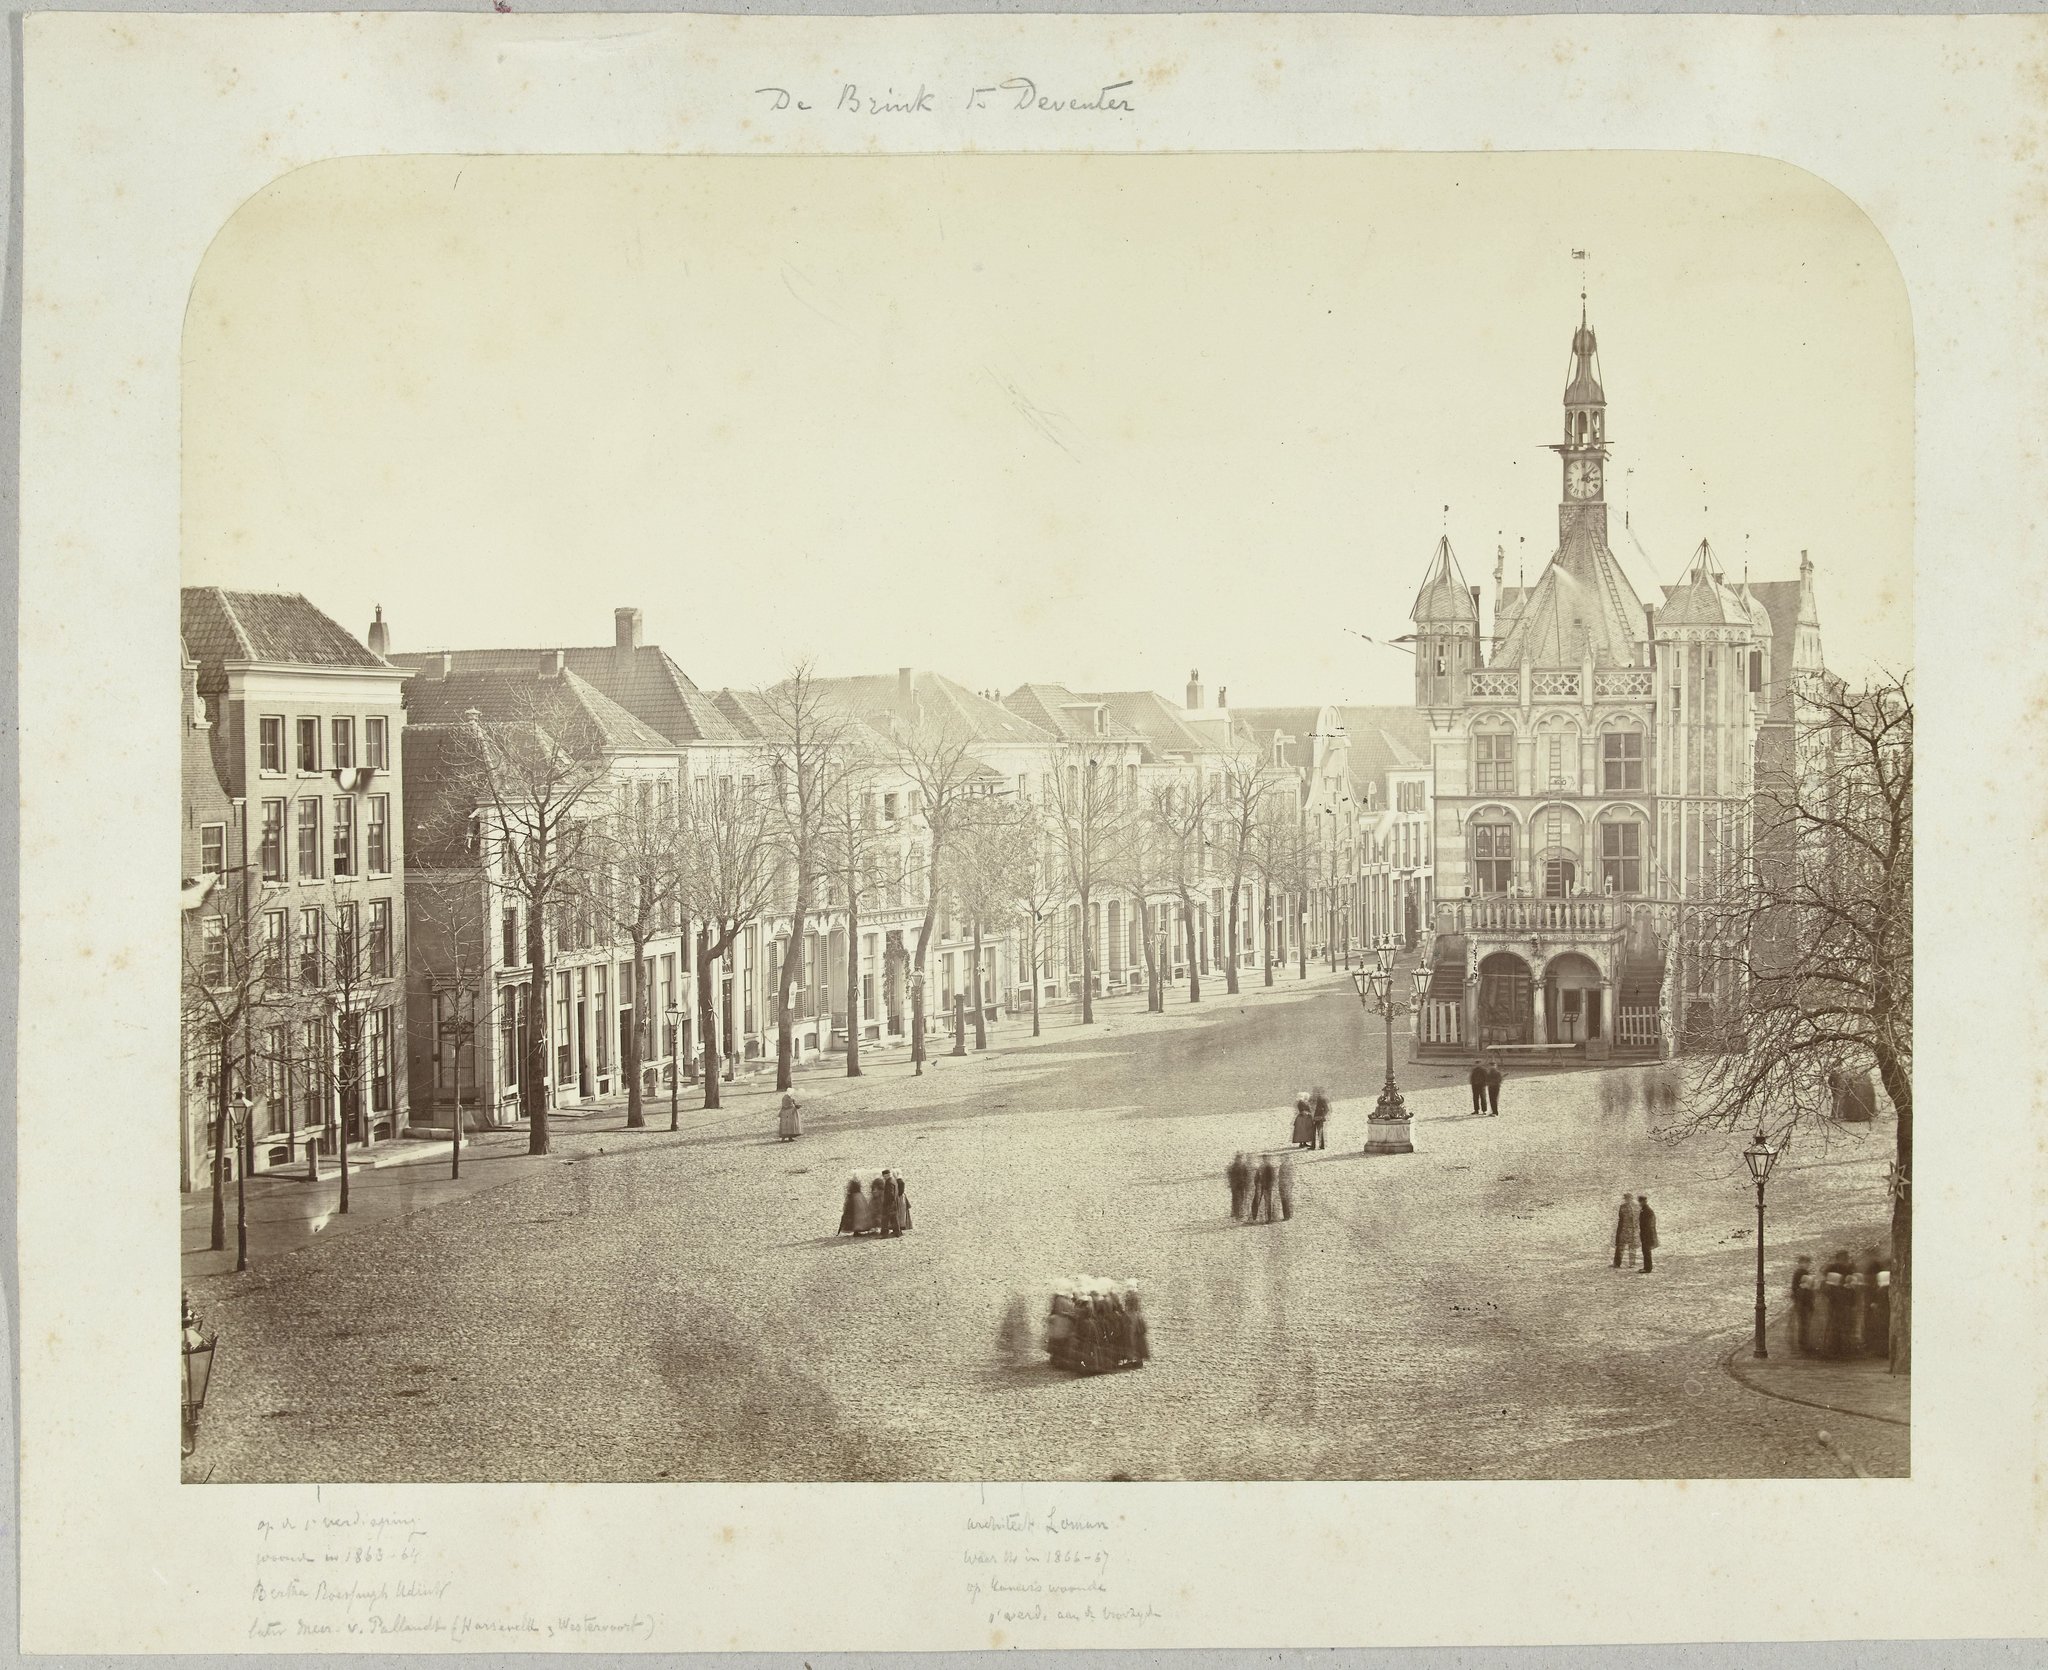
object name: photograph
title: De Brink te Deventer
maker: johann heinrich martin bosse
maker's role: fotograaf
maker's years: 1838-1901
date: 1873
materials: cardboard, paper, photographic support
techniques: albumen print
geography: deventer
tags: square, place, circus, etc., deventer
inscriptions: annotation: ‘o pde 1e verdieping woonde in 1863-1864 Bertha Roes... Udink later mevr. Pallandt (Harseveld, Westervoort)./ Architect Loman waar ik in 1866-1867 op kamers woonde IIe verd aan de voorzijde’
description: De waag op de Brink in Deventer, op het plein loopt een aantal mensen in klederdracht